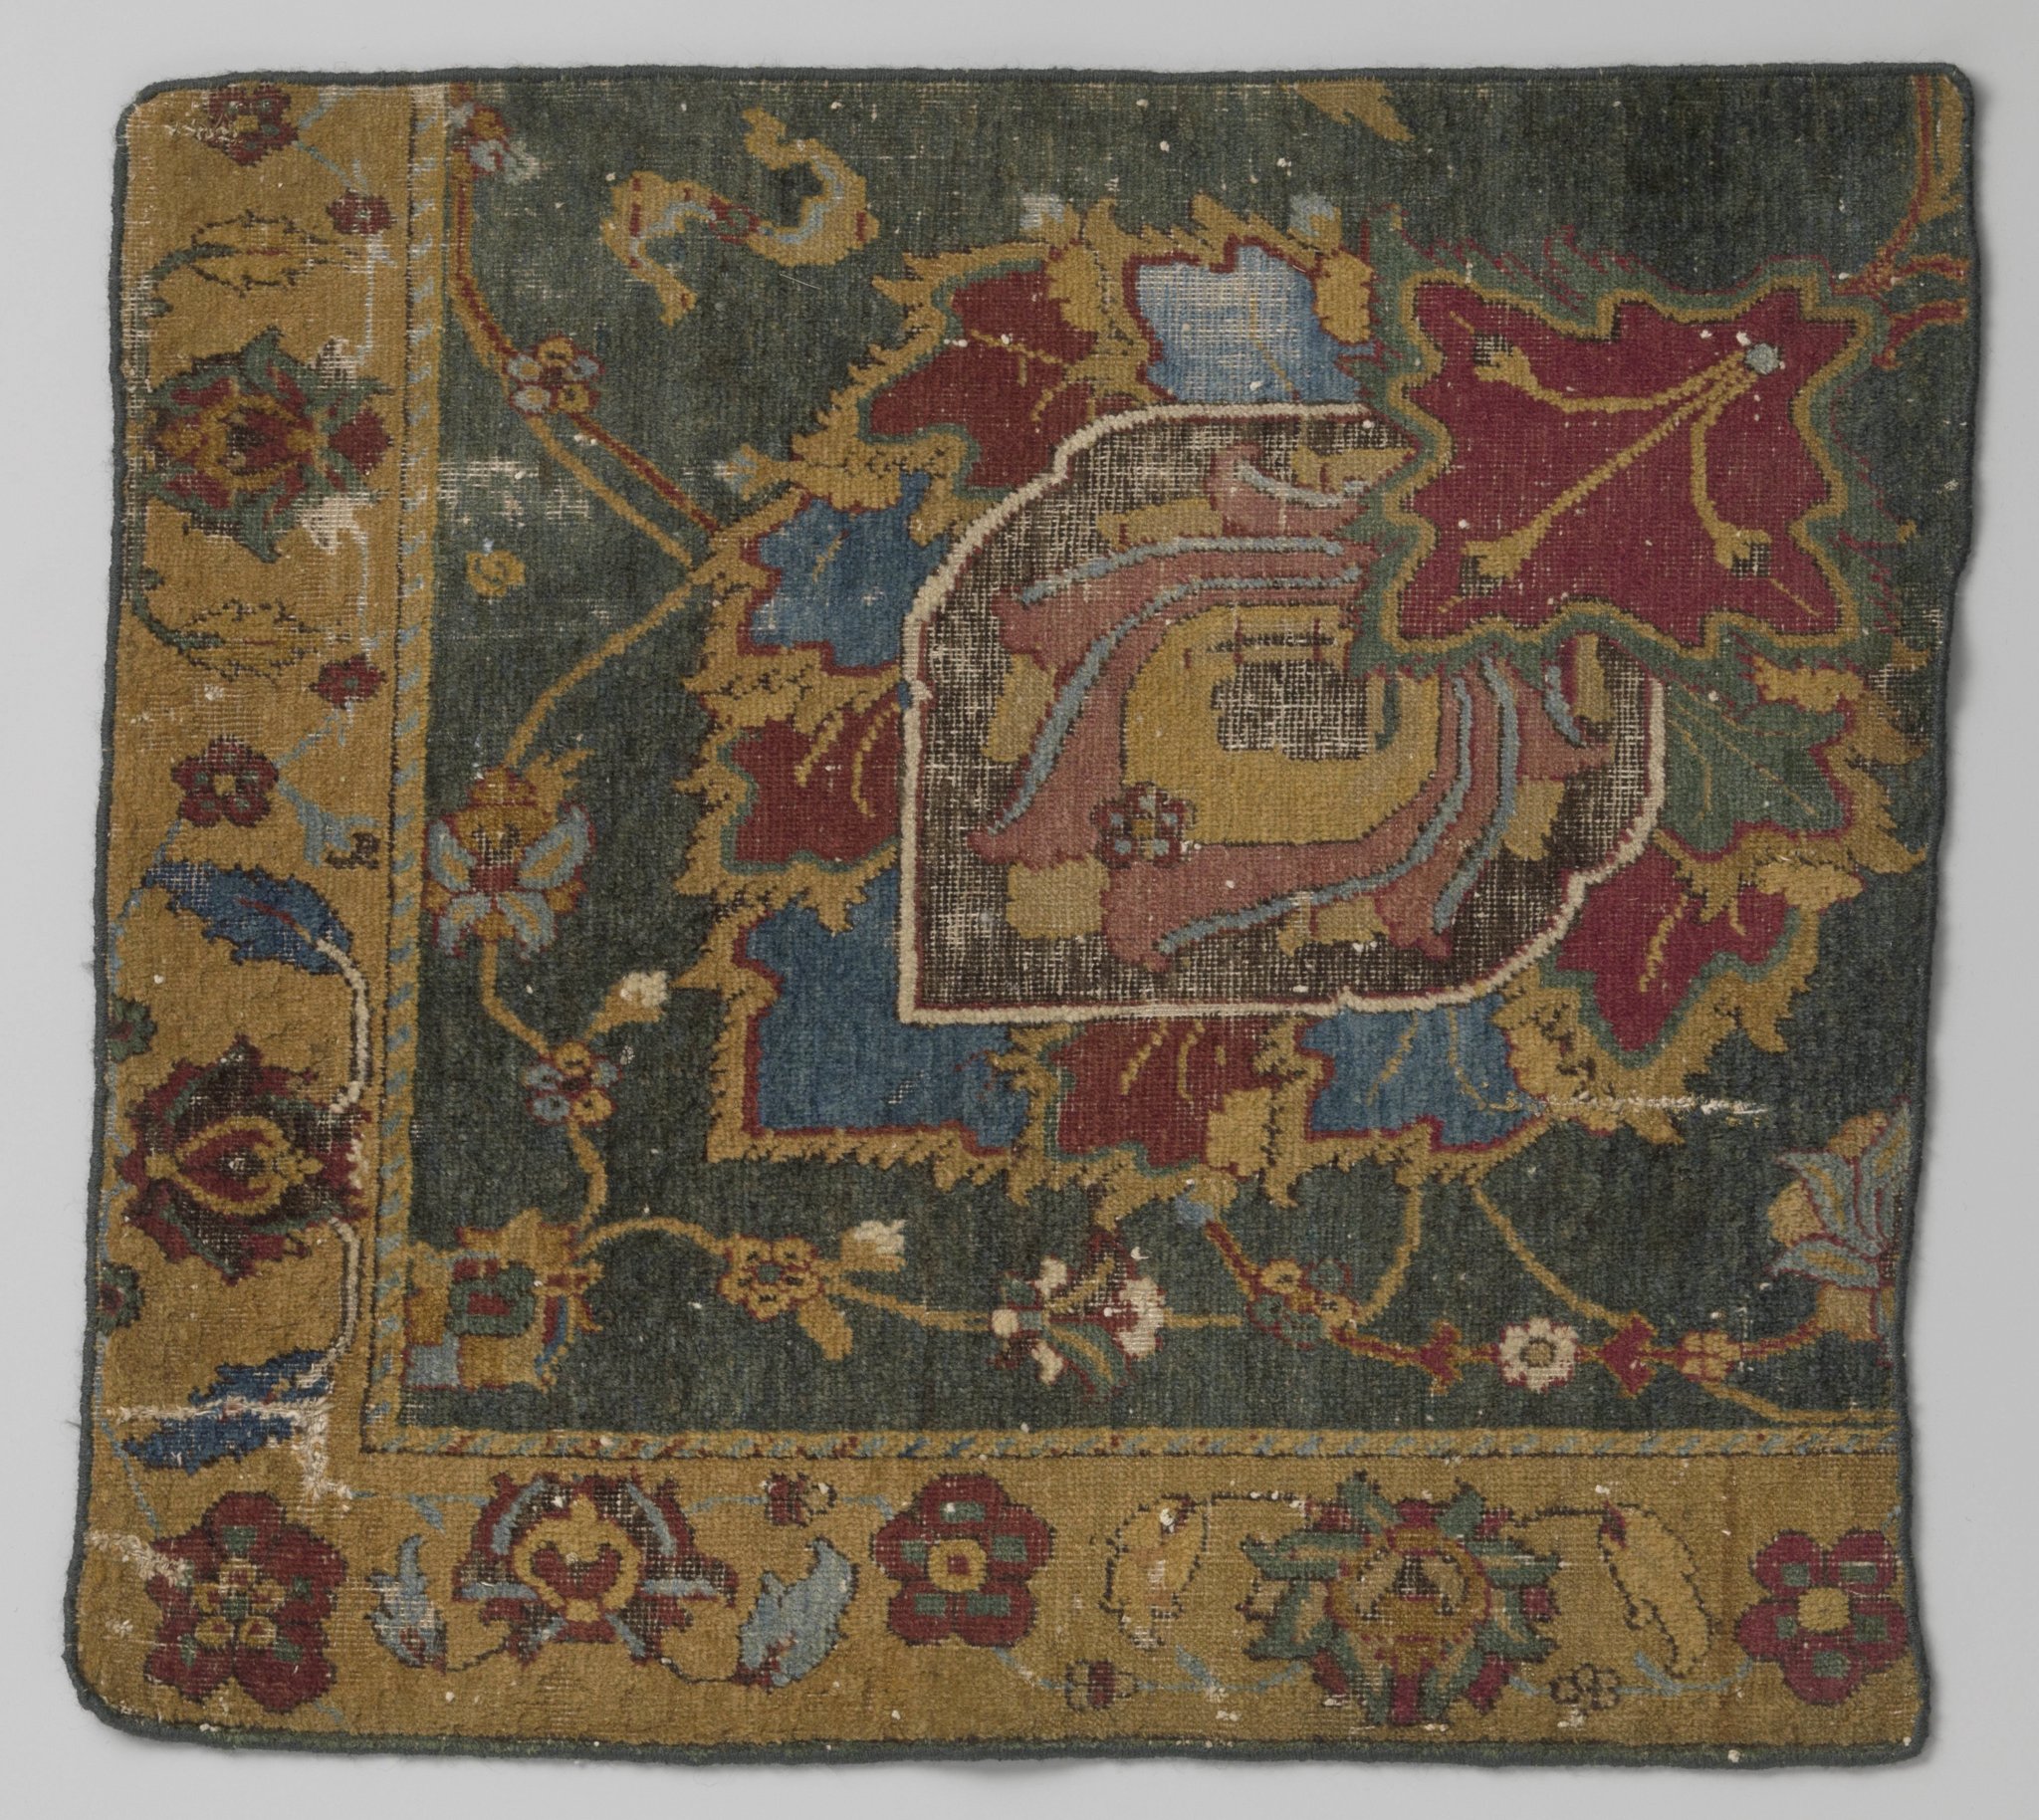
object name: oriental rug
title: Hoekfragment van een oosters tapijt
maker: Anonymous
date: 1600-1650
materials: wool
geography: iran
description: De middenrand is versierd met een palmet, ranken, lotussen en een wolkenband tegen een groen fond. Op de buitenzoom staan afwisselend een lotus en rozet.